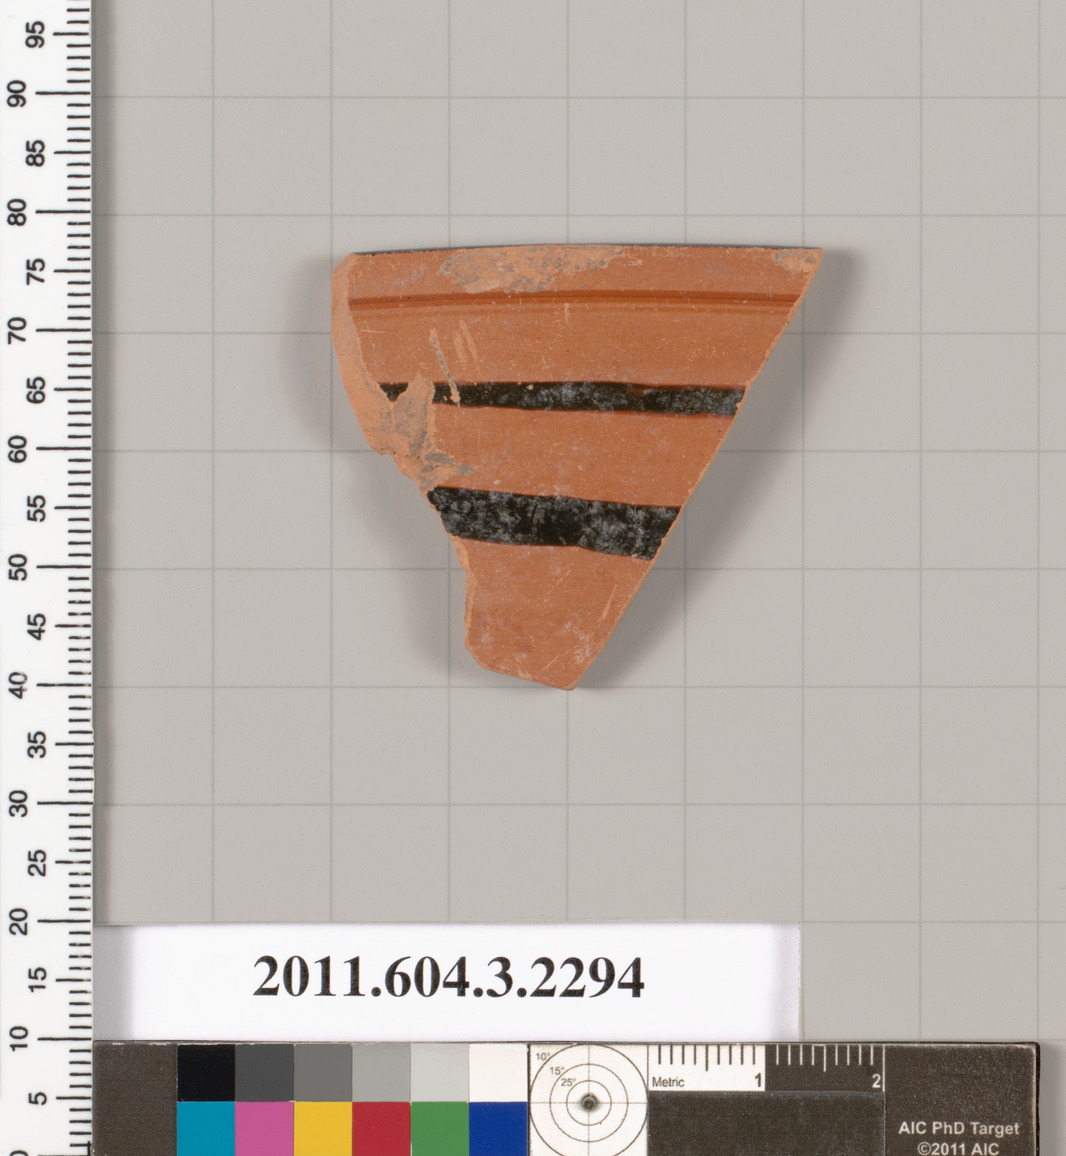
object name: kylix fragment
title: Terracotta rim fragment of a kylix: eye-cup (drinking cup)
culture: greek, attic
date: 540-500 BCE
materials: terracotta